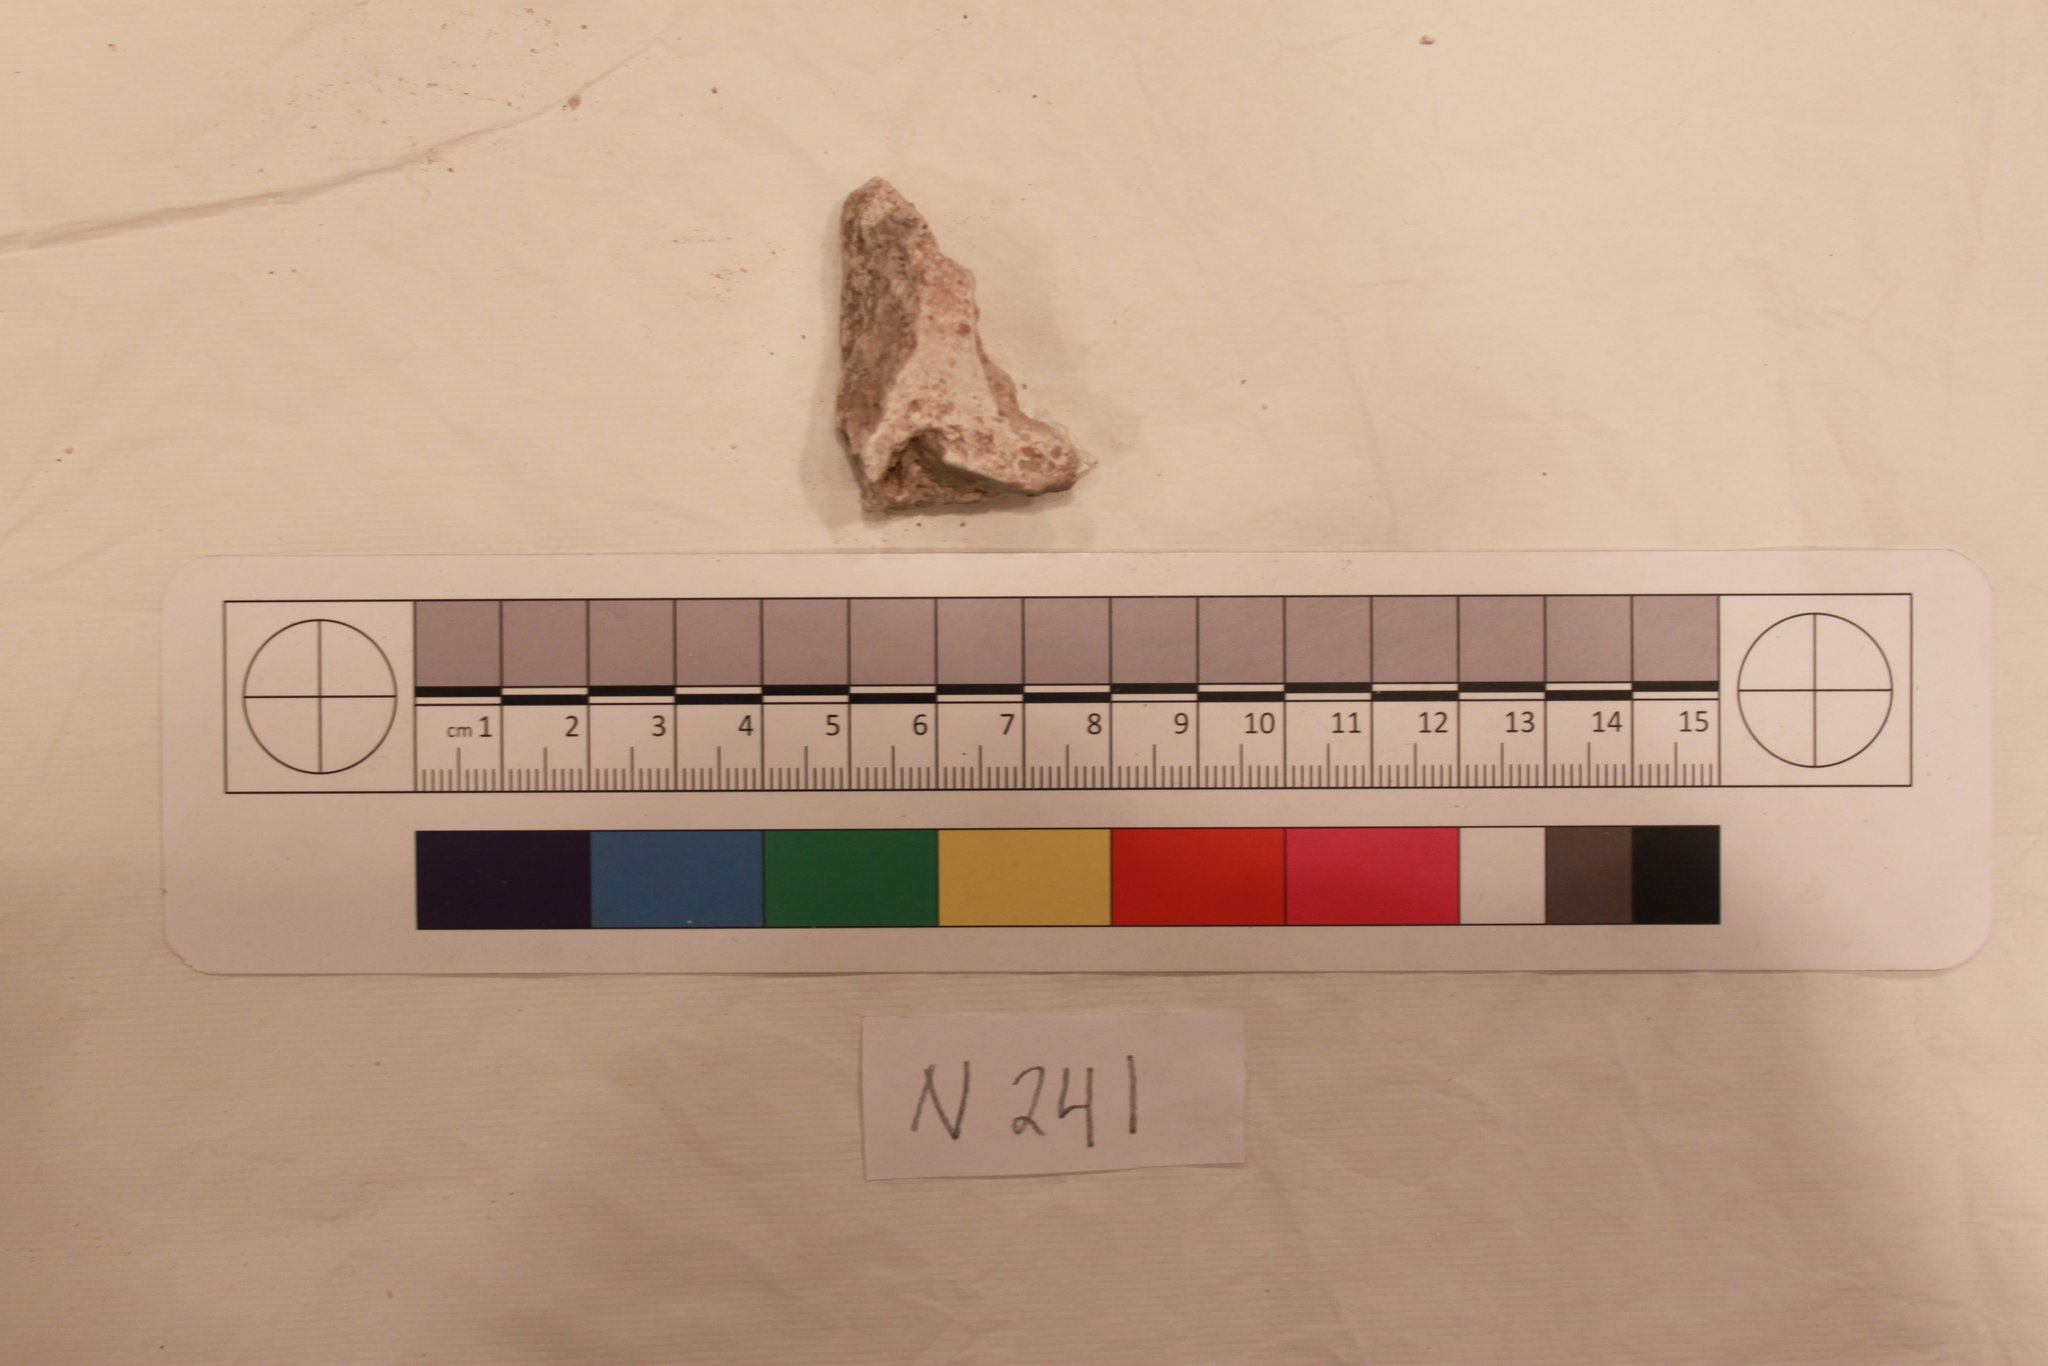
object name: fragment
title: Stucco Fragment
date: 701-1200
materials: plaster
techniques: carving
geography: iran